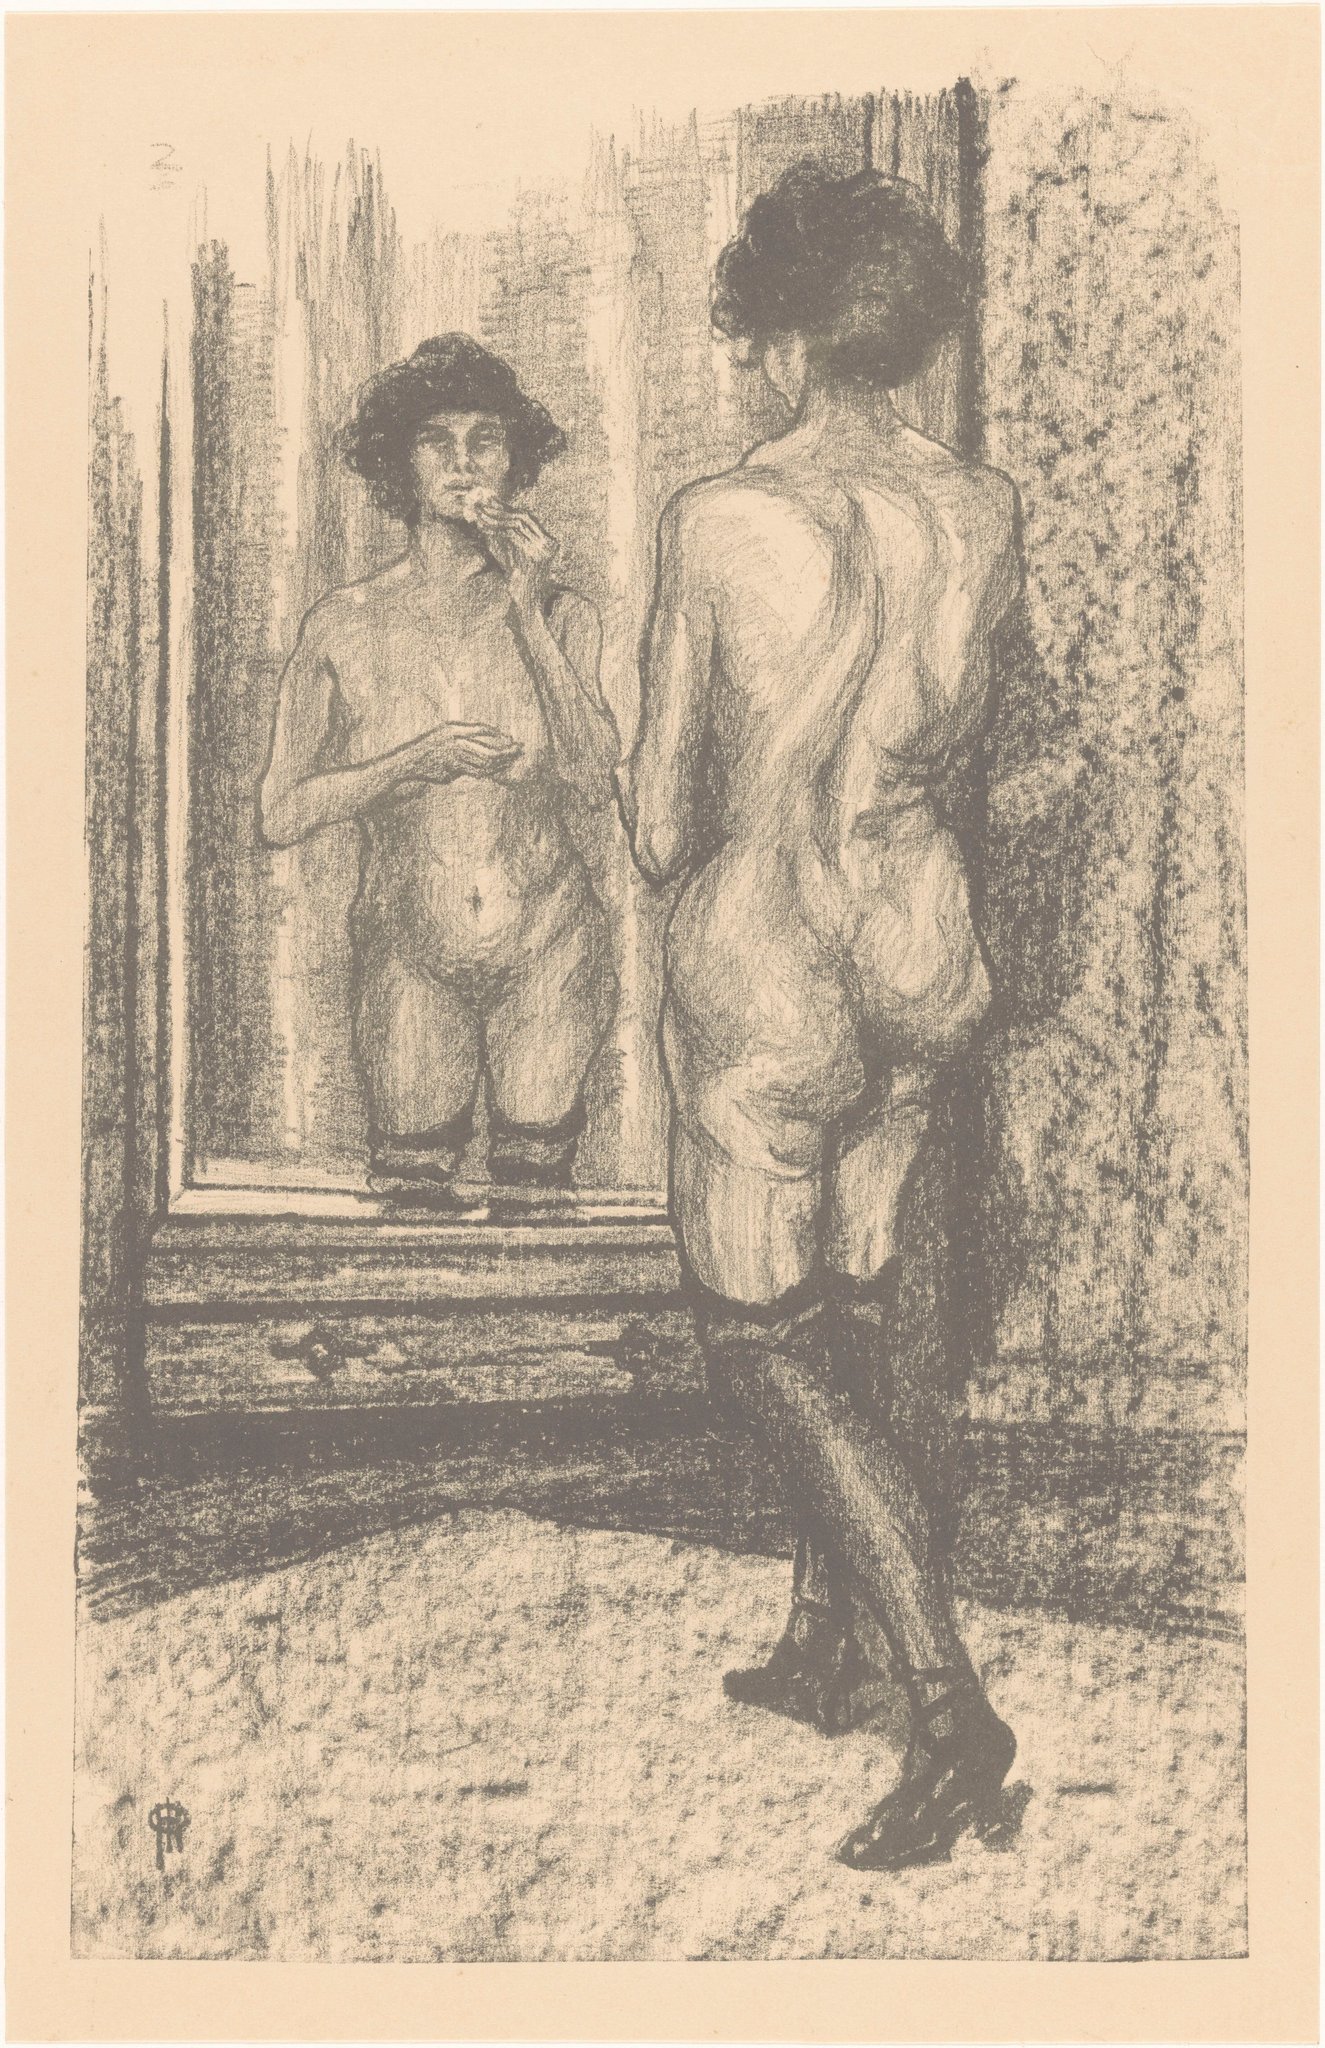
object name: print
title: IJdelheid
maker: otto hanrath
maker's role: print maker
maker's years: 1882-1944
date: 1923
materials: paper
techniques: lithograph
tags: mirror, woman (showing herself) undressed, quasi-nude, (woman) looking in a mirror ~ scene symbolizing 'vanitas'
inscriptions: collector's mark: Lugt 2228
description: Een halfnaakte vrouw, die kousen en pumps draagt, bekijkt zichzelf in een spiegel.